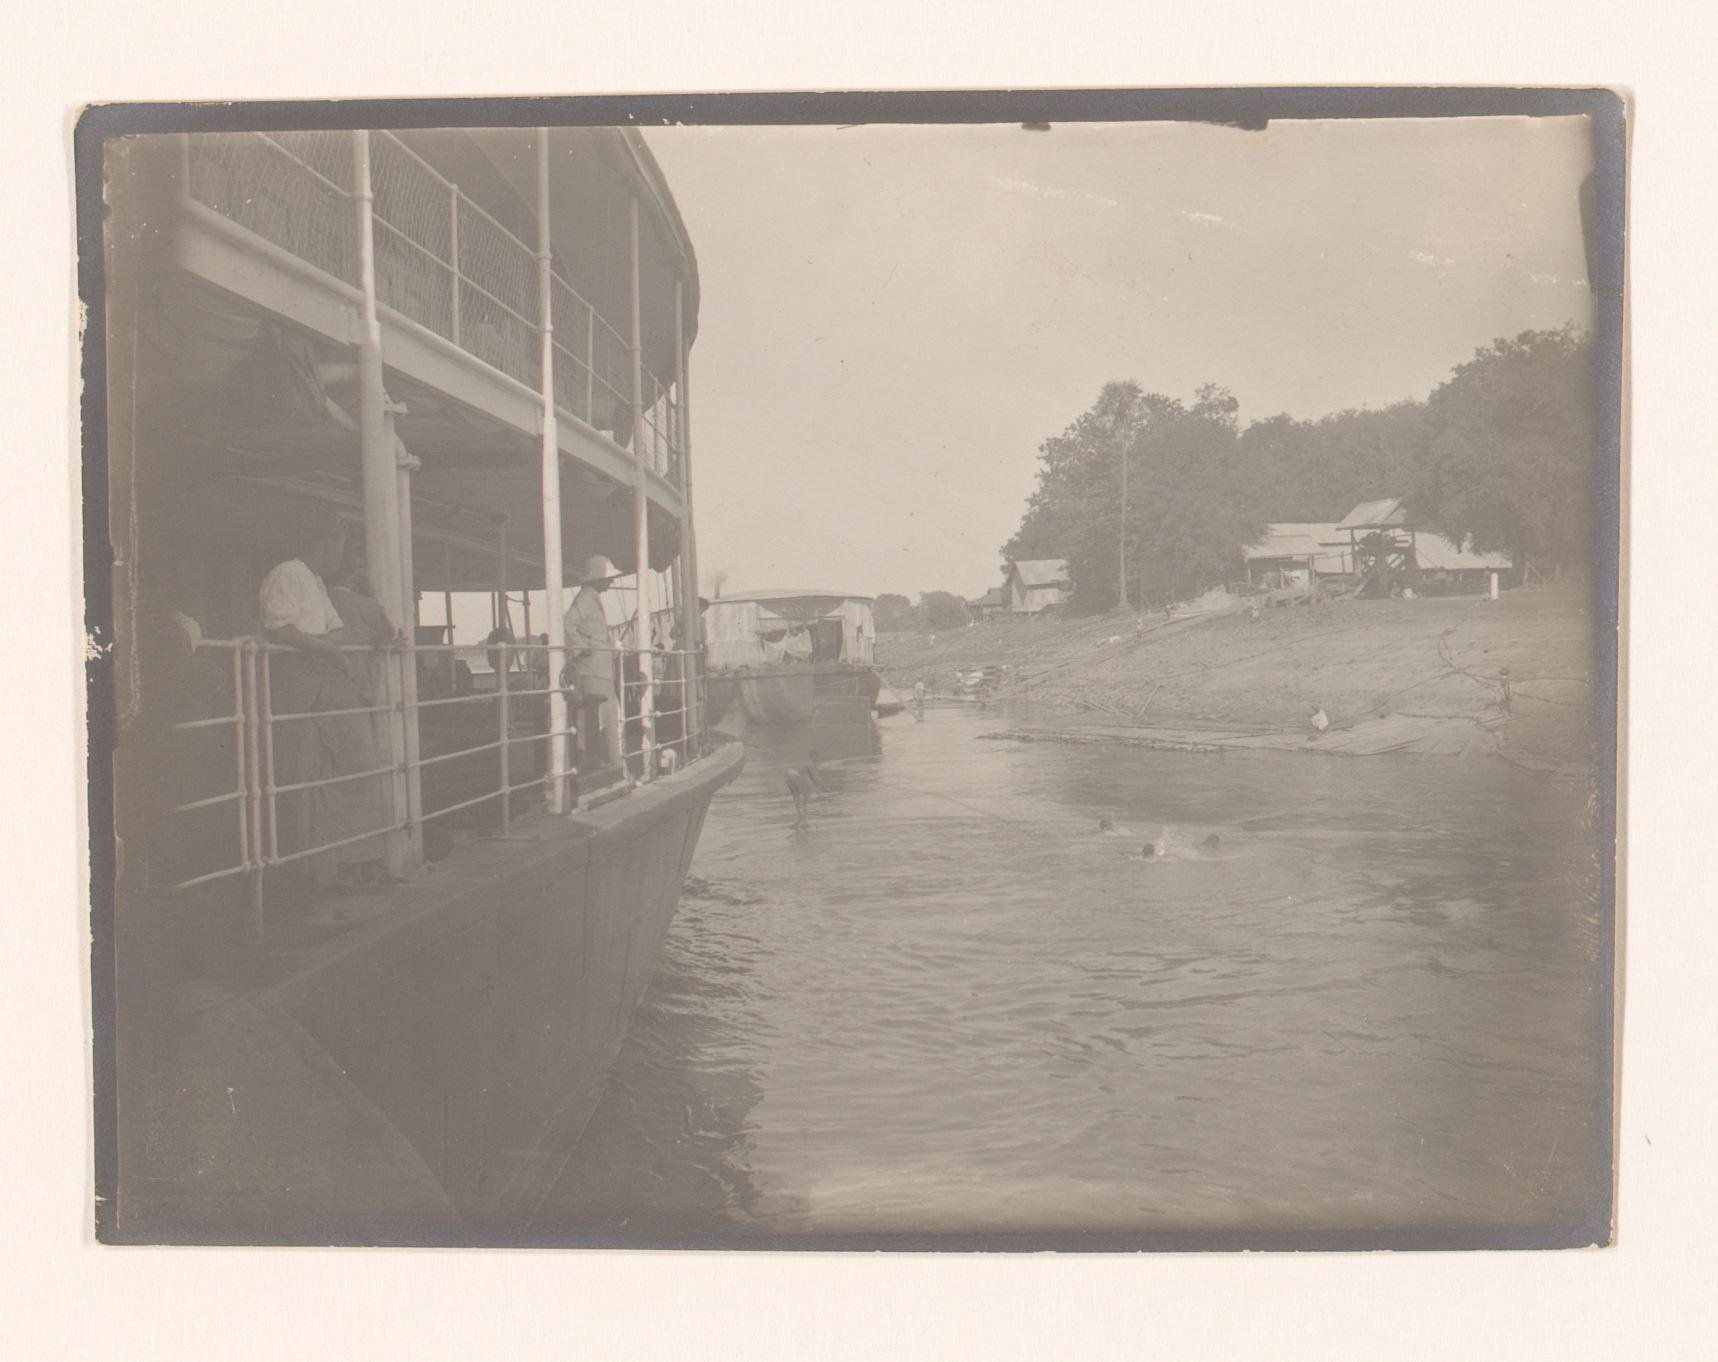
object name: photograph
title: Een passagiersschip bij de oever van een rivier, Zuid-Oost Azië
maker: jan adriani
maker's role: fotograaf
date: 1907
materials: photographic support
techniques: gelatin silver print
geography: southeast asia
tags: ships (in general)